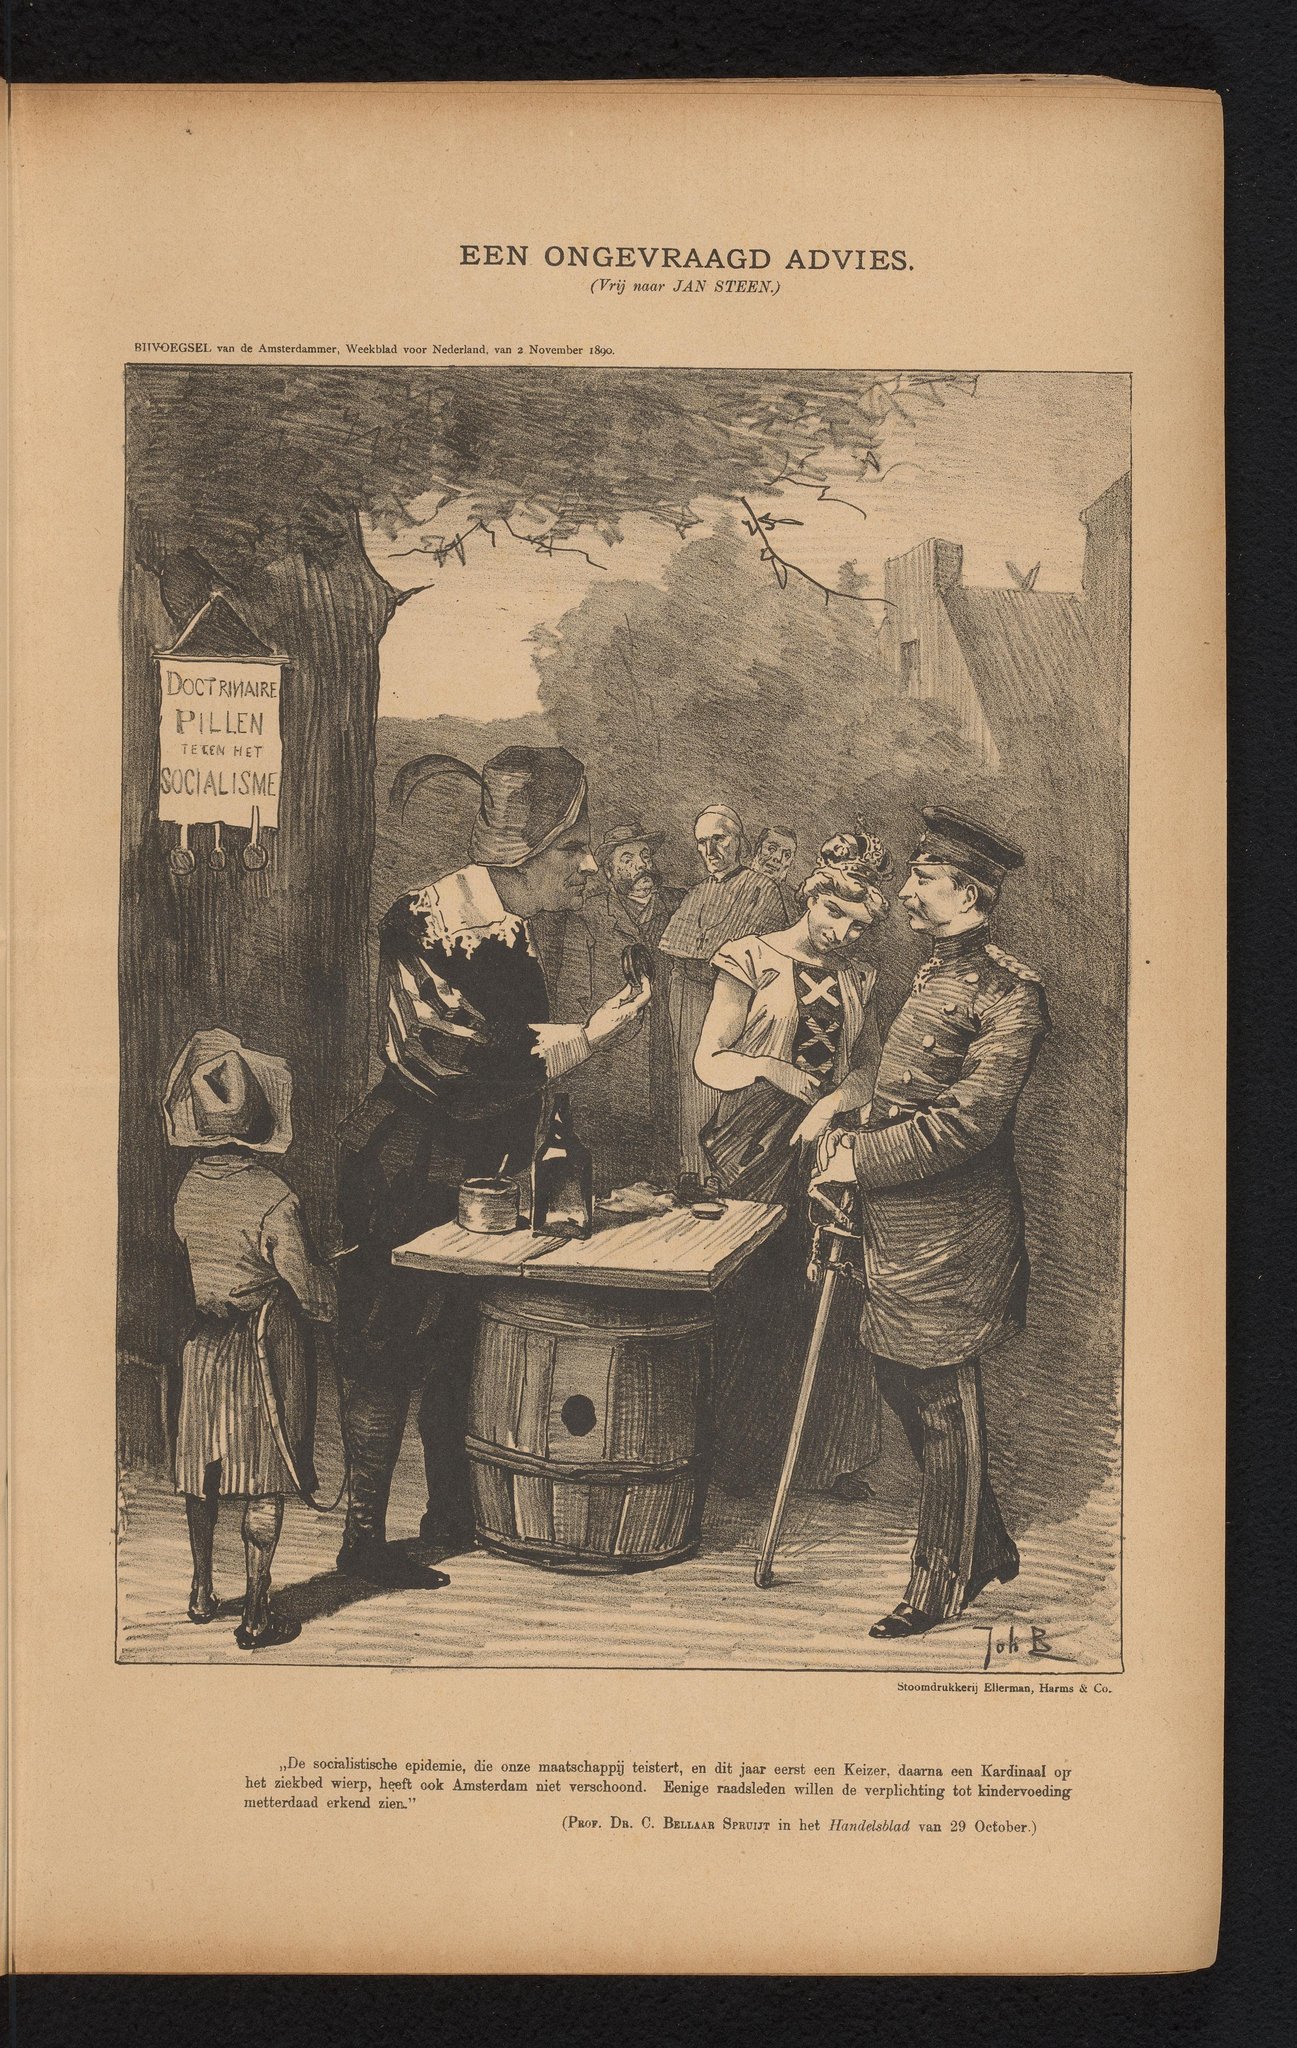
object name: cartoon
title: Een ongevraagd advies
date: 1890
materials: paper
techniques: lithograph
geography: amsterdam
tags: wilhelm ii (keizer van duitsland), personification of a city, town-patron(ess), quack, charlatan, mountebank, 'saltimbanco', political caricatures and satires, amsterdam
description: Cornelis Bellaar Spruijt als een kwakzalver die probeert zijn pillen tegen het socialisme te slijten aan de Duitse keizer Wilhelm II. De stadsmaagd van Amsterdam en een jongen kijken toe.